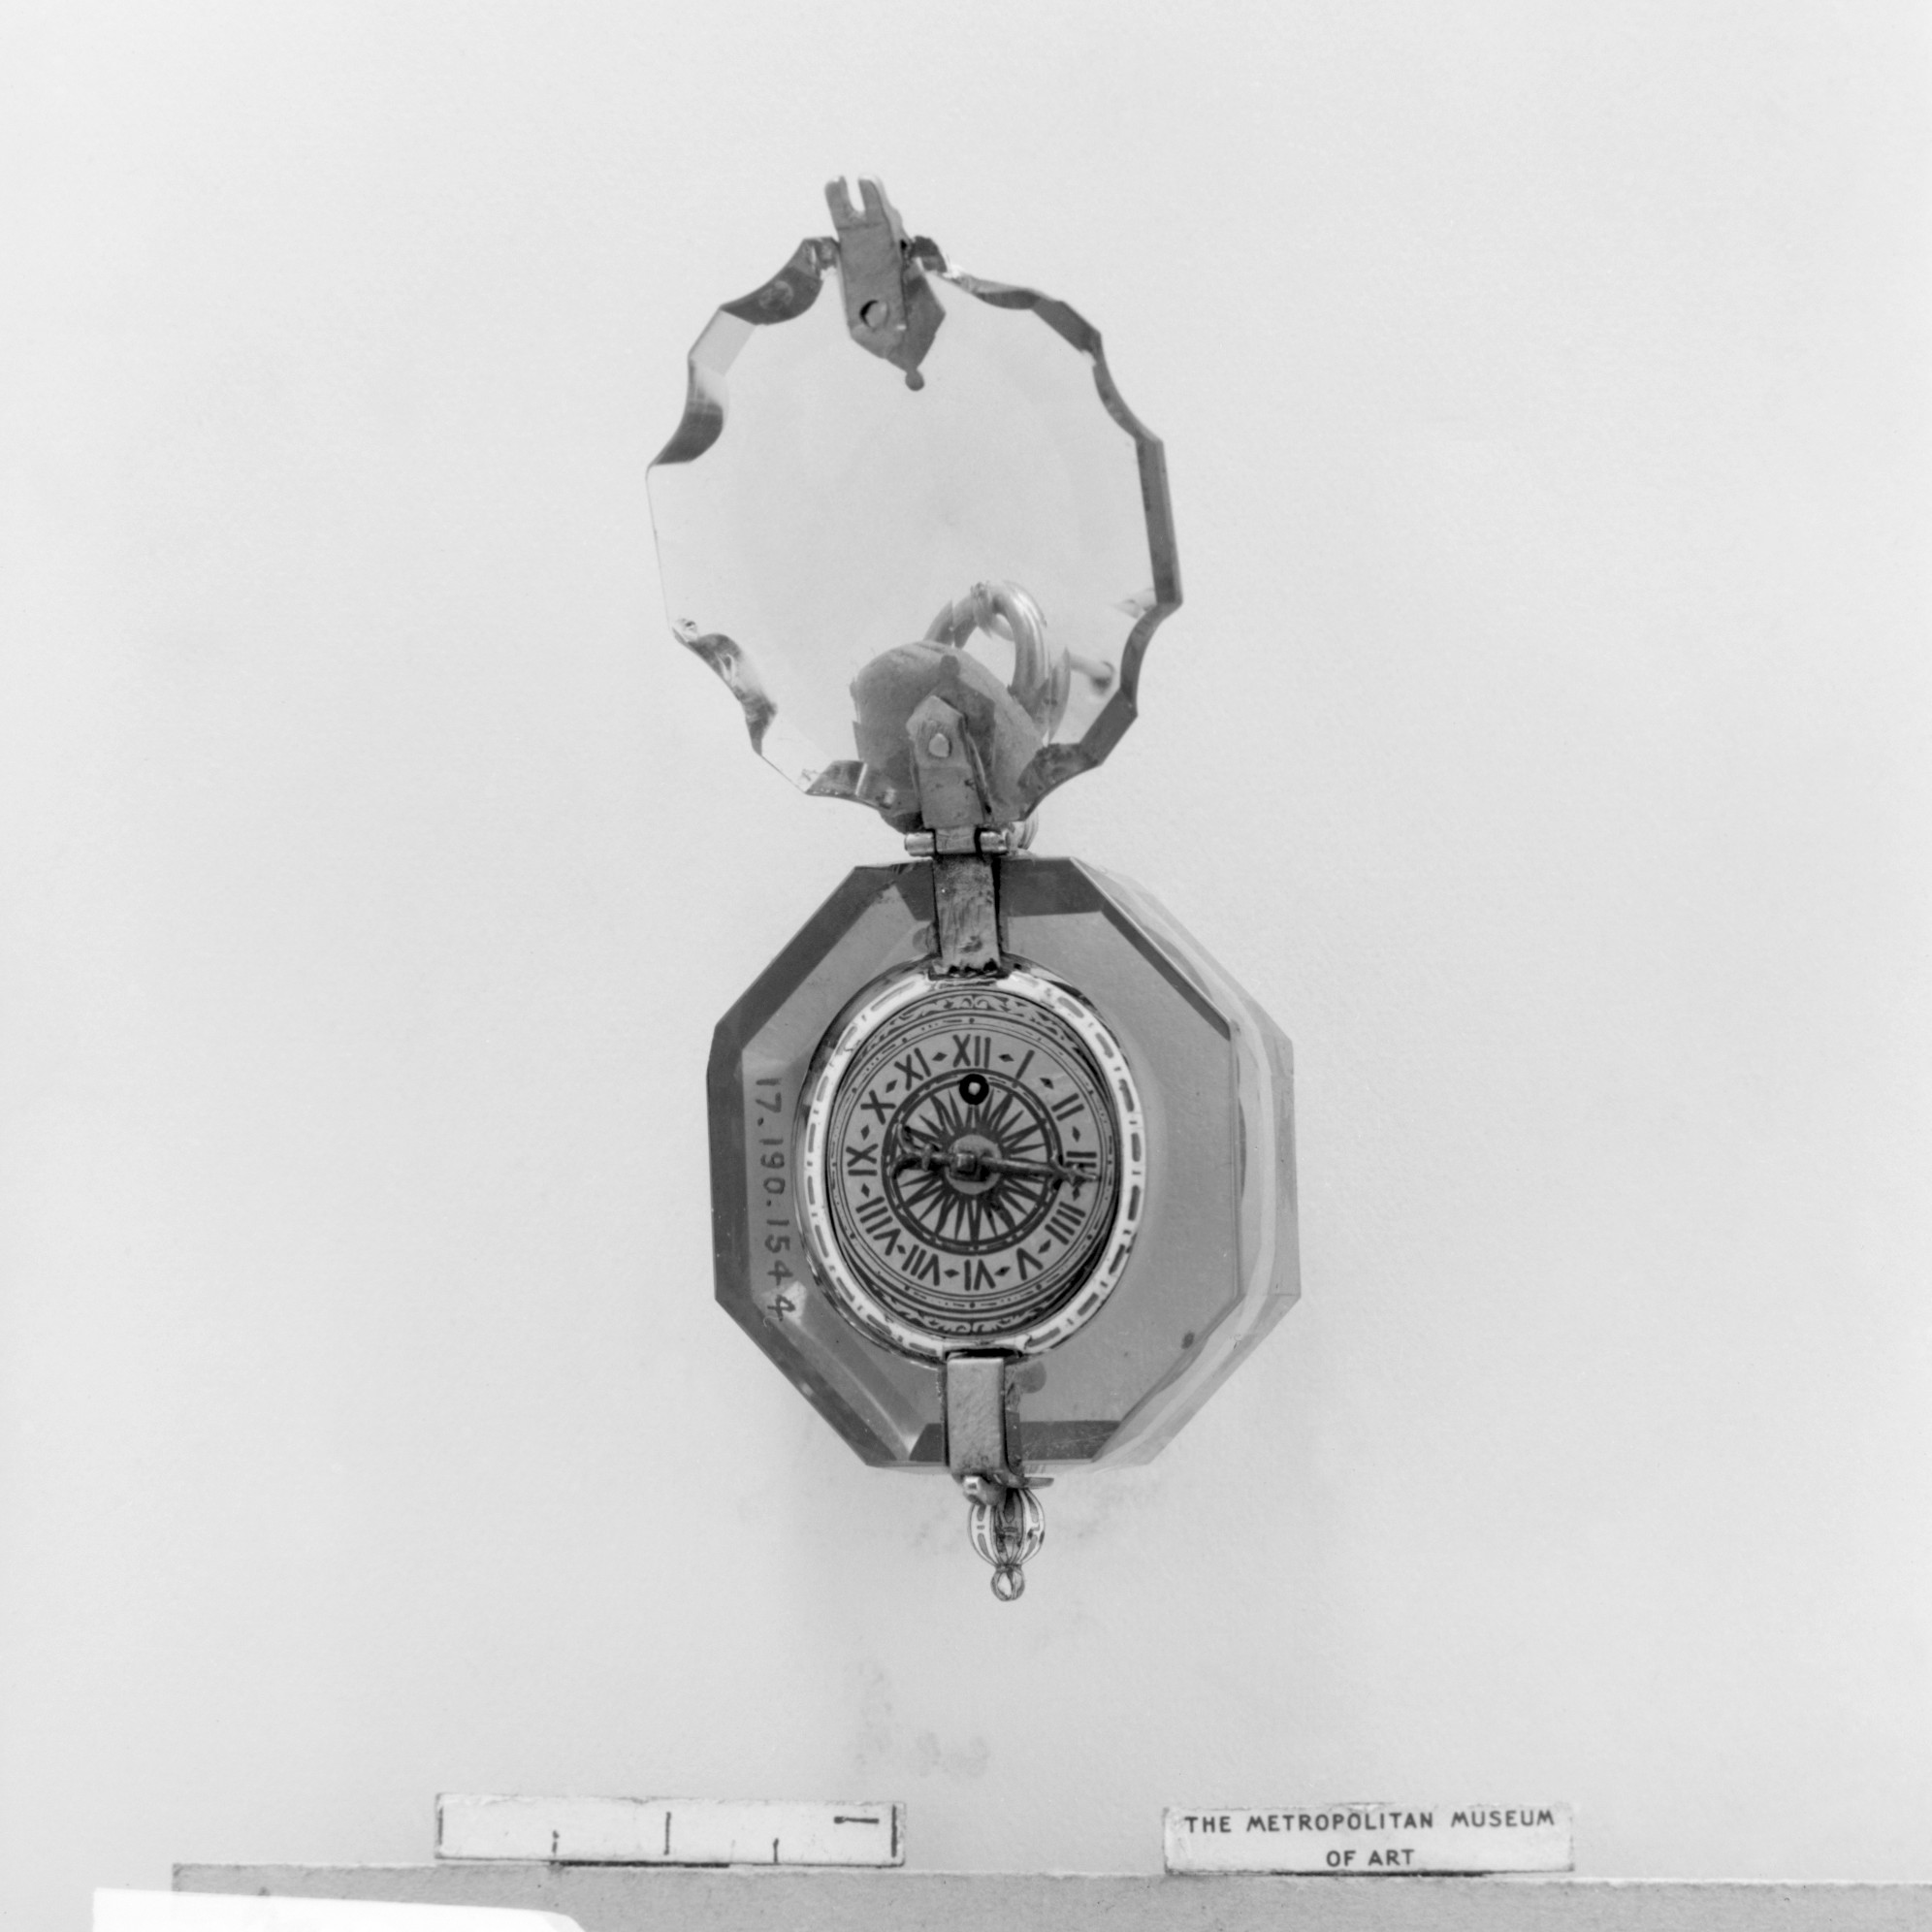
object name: watch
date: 1801-1900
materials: crystal, enamel, gemstone